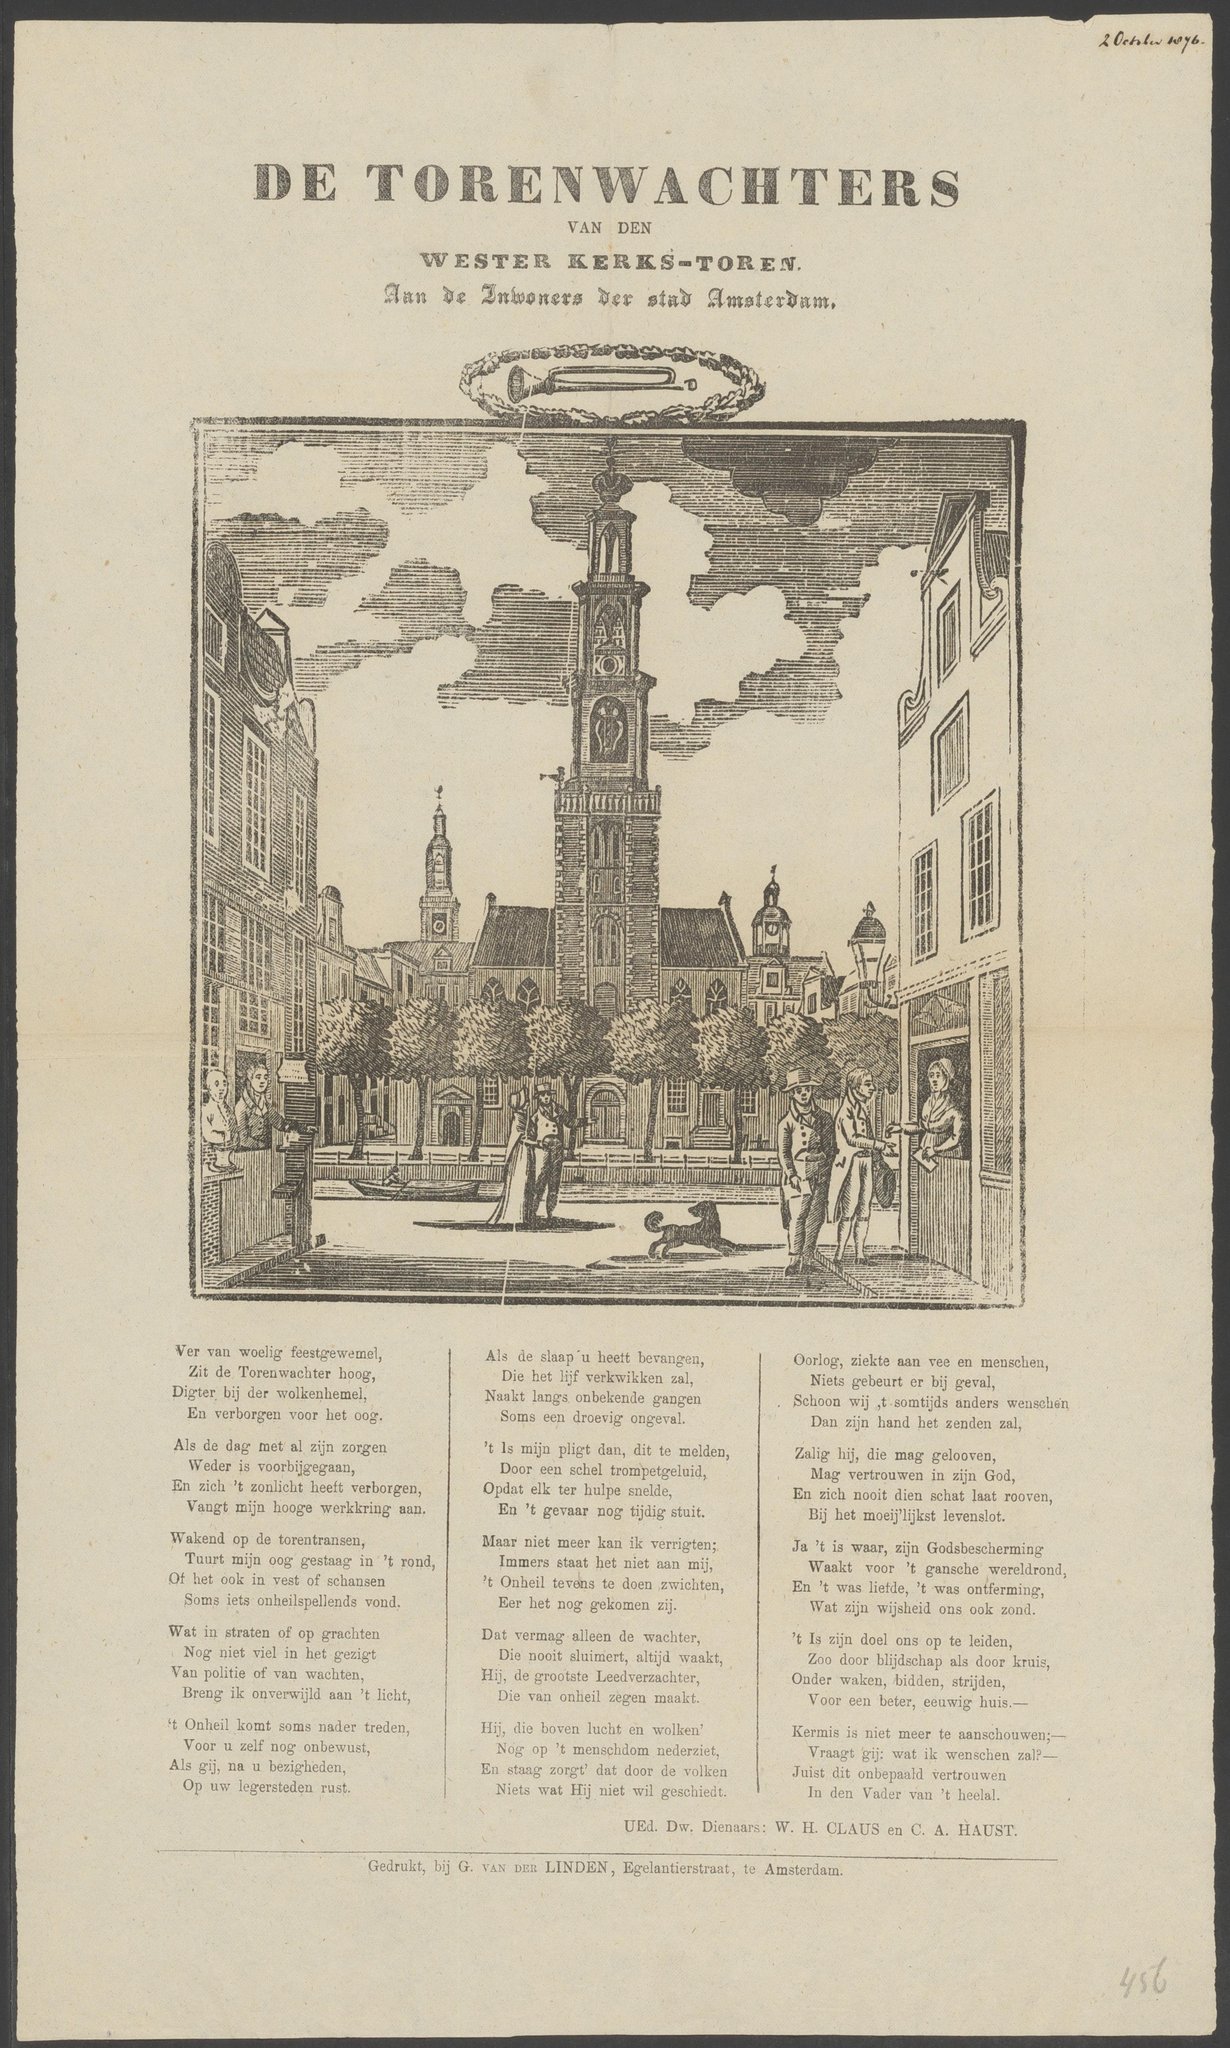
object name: print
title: Kermiswens van de torenwachters van de stad Amsterdam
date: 1875-1876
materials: paper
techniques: letterpress printing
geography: amsterdam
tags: night patrol, tower (of house or building)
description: Kermiswens van de torenwachters van de stad Amsterdam. Bovenaan een trompet met daaronder een een toren in de stad Amterdam met een torenwachter. Onderaan een vers in twee kolommen. Aangeboden door de torenwachters van de toren van de Westerkerk: W.H. Claus en C.A. Haust. Onderwerpsrubrieken binnen de Atlas Zeden en Gewoonten: Zeden en gewoonten in engeren zin, Volksleven, Volksbladen, Nieuwjaars- en Kerstwenschen, Amsterdam.